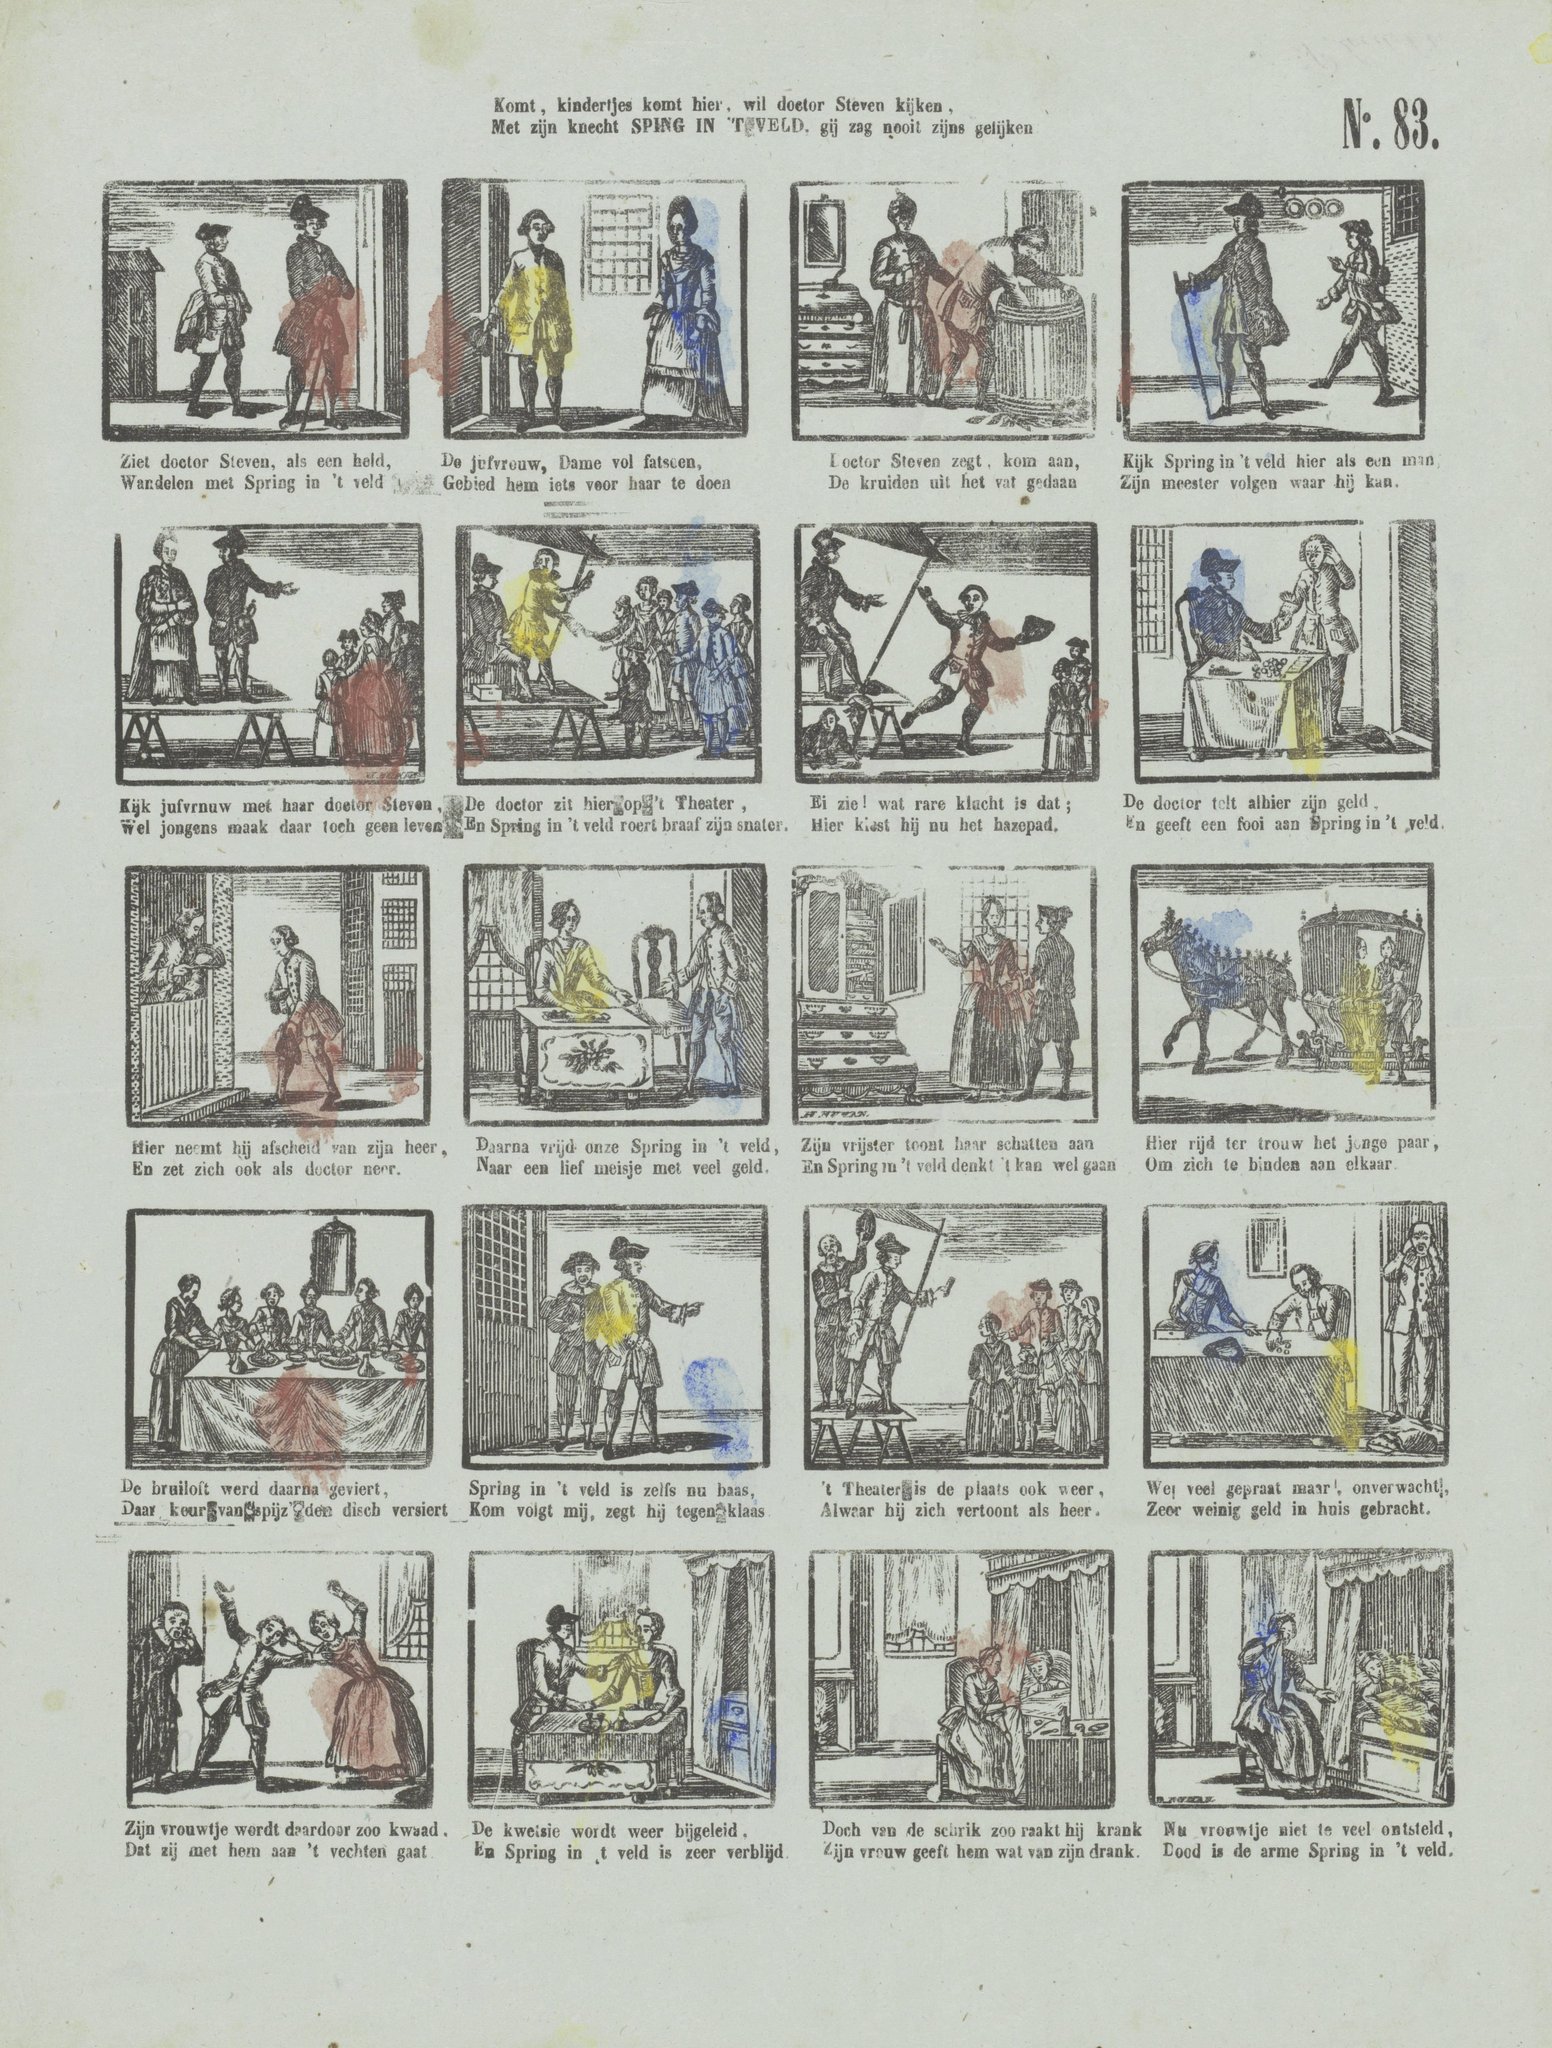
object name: print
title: Komt, kindertjes komt hier, wilt doctor Steven kijken, / Met zijn knecht Spring in 't Veld, gij zag nooit zijns gelijken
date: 1850-1870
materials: paper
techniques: colour, letterpress printing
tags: quack, charlatan, mountebank, 'saltimbanco', man and wife quarrelling, 'marriage à la mode'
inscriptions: collector's mark: Lugt 2760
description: Blad met 20 voorstellingen over het leven van de kwakzalver dr. Steeven en zijn knecht Spring in 't Veld. Onder elke voorstelling een vierregelig vers. Genummerd rechtsboven: No. 83.